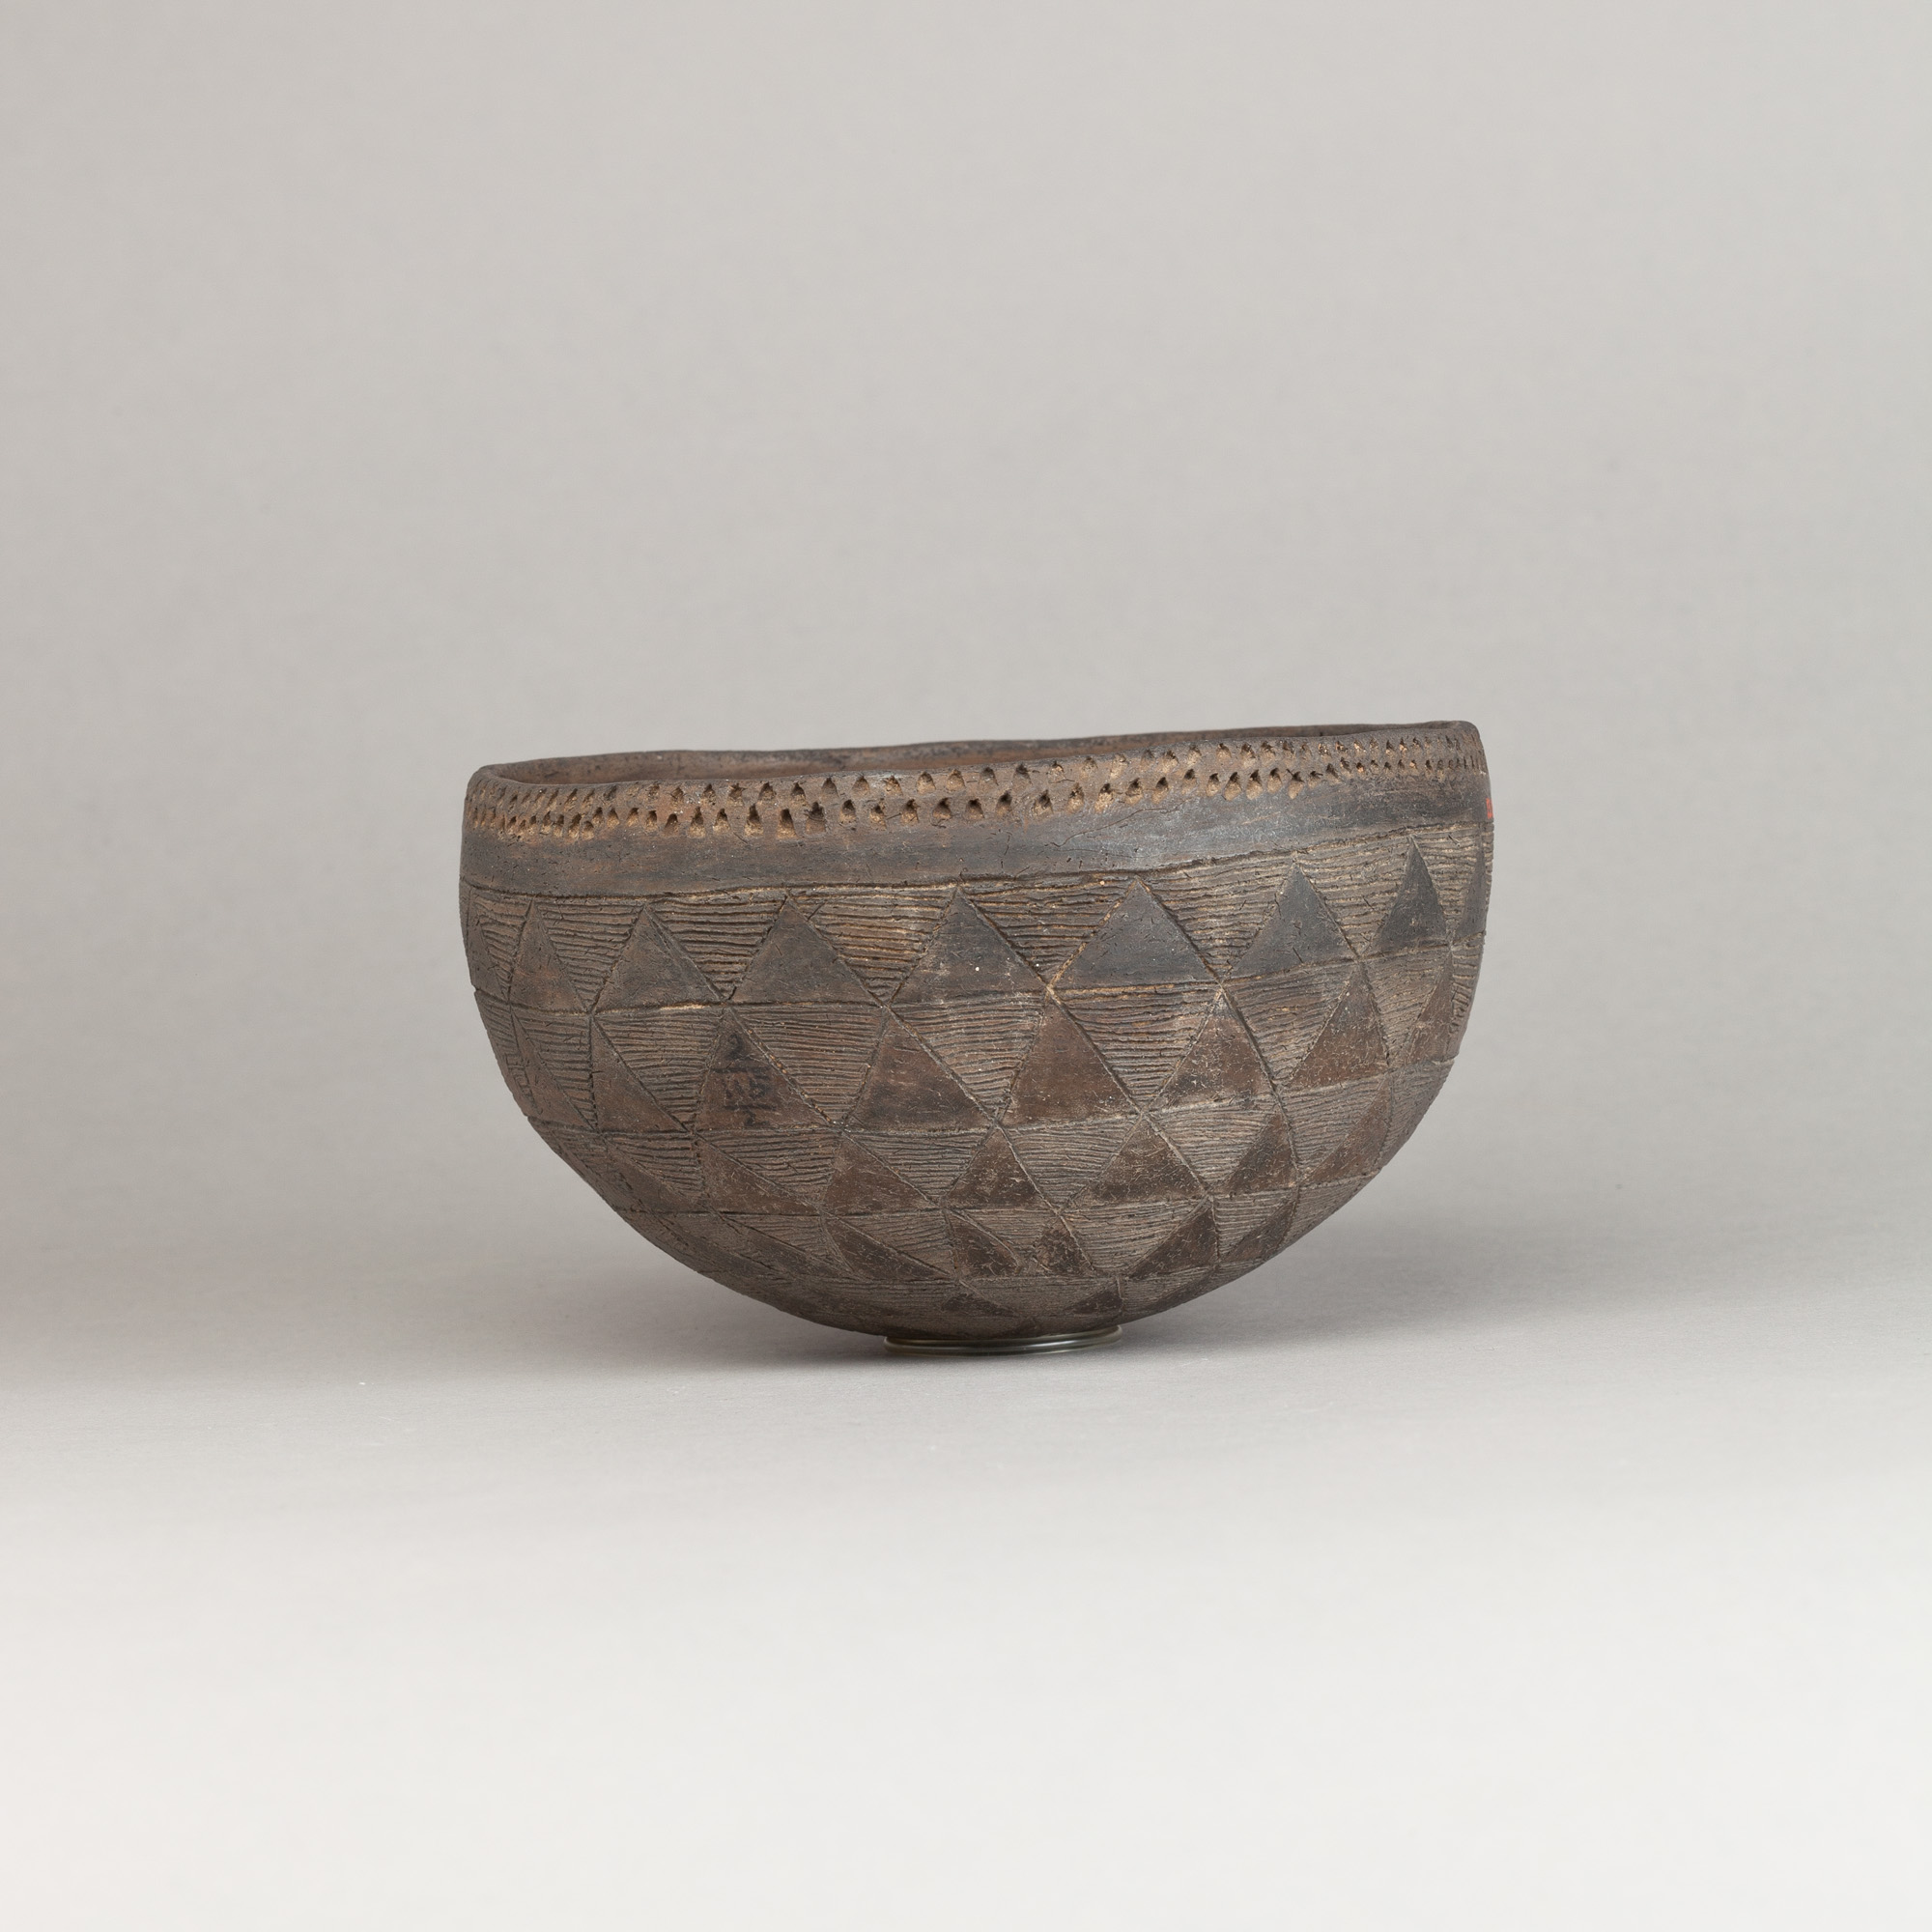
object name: cup, geometric decoration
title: Drinking Cup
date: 1900-1550 BCE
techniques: polish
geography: nubia